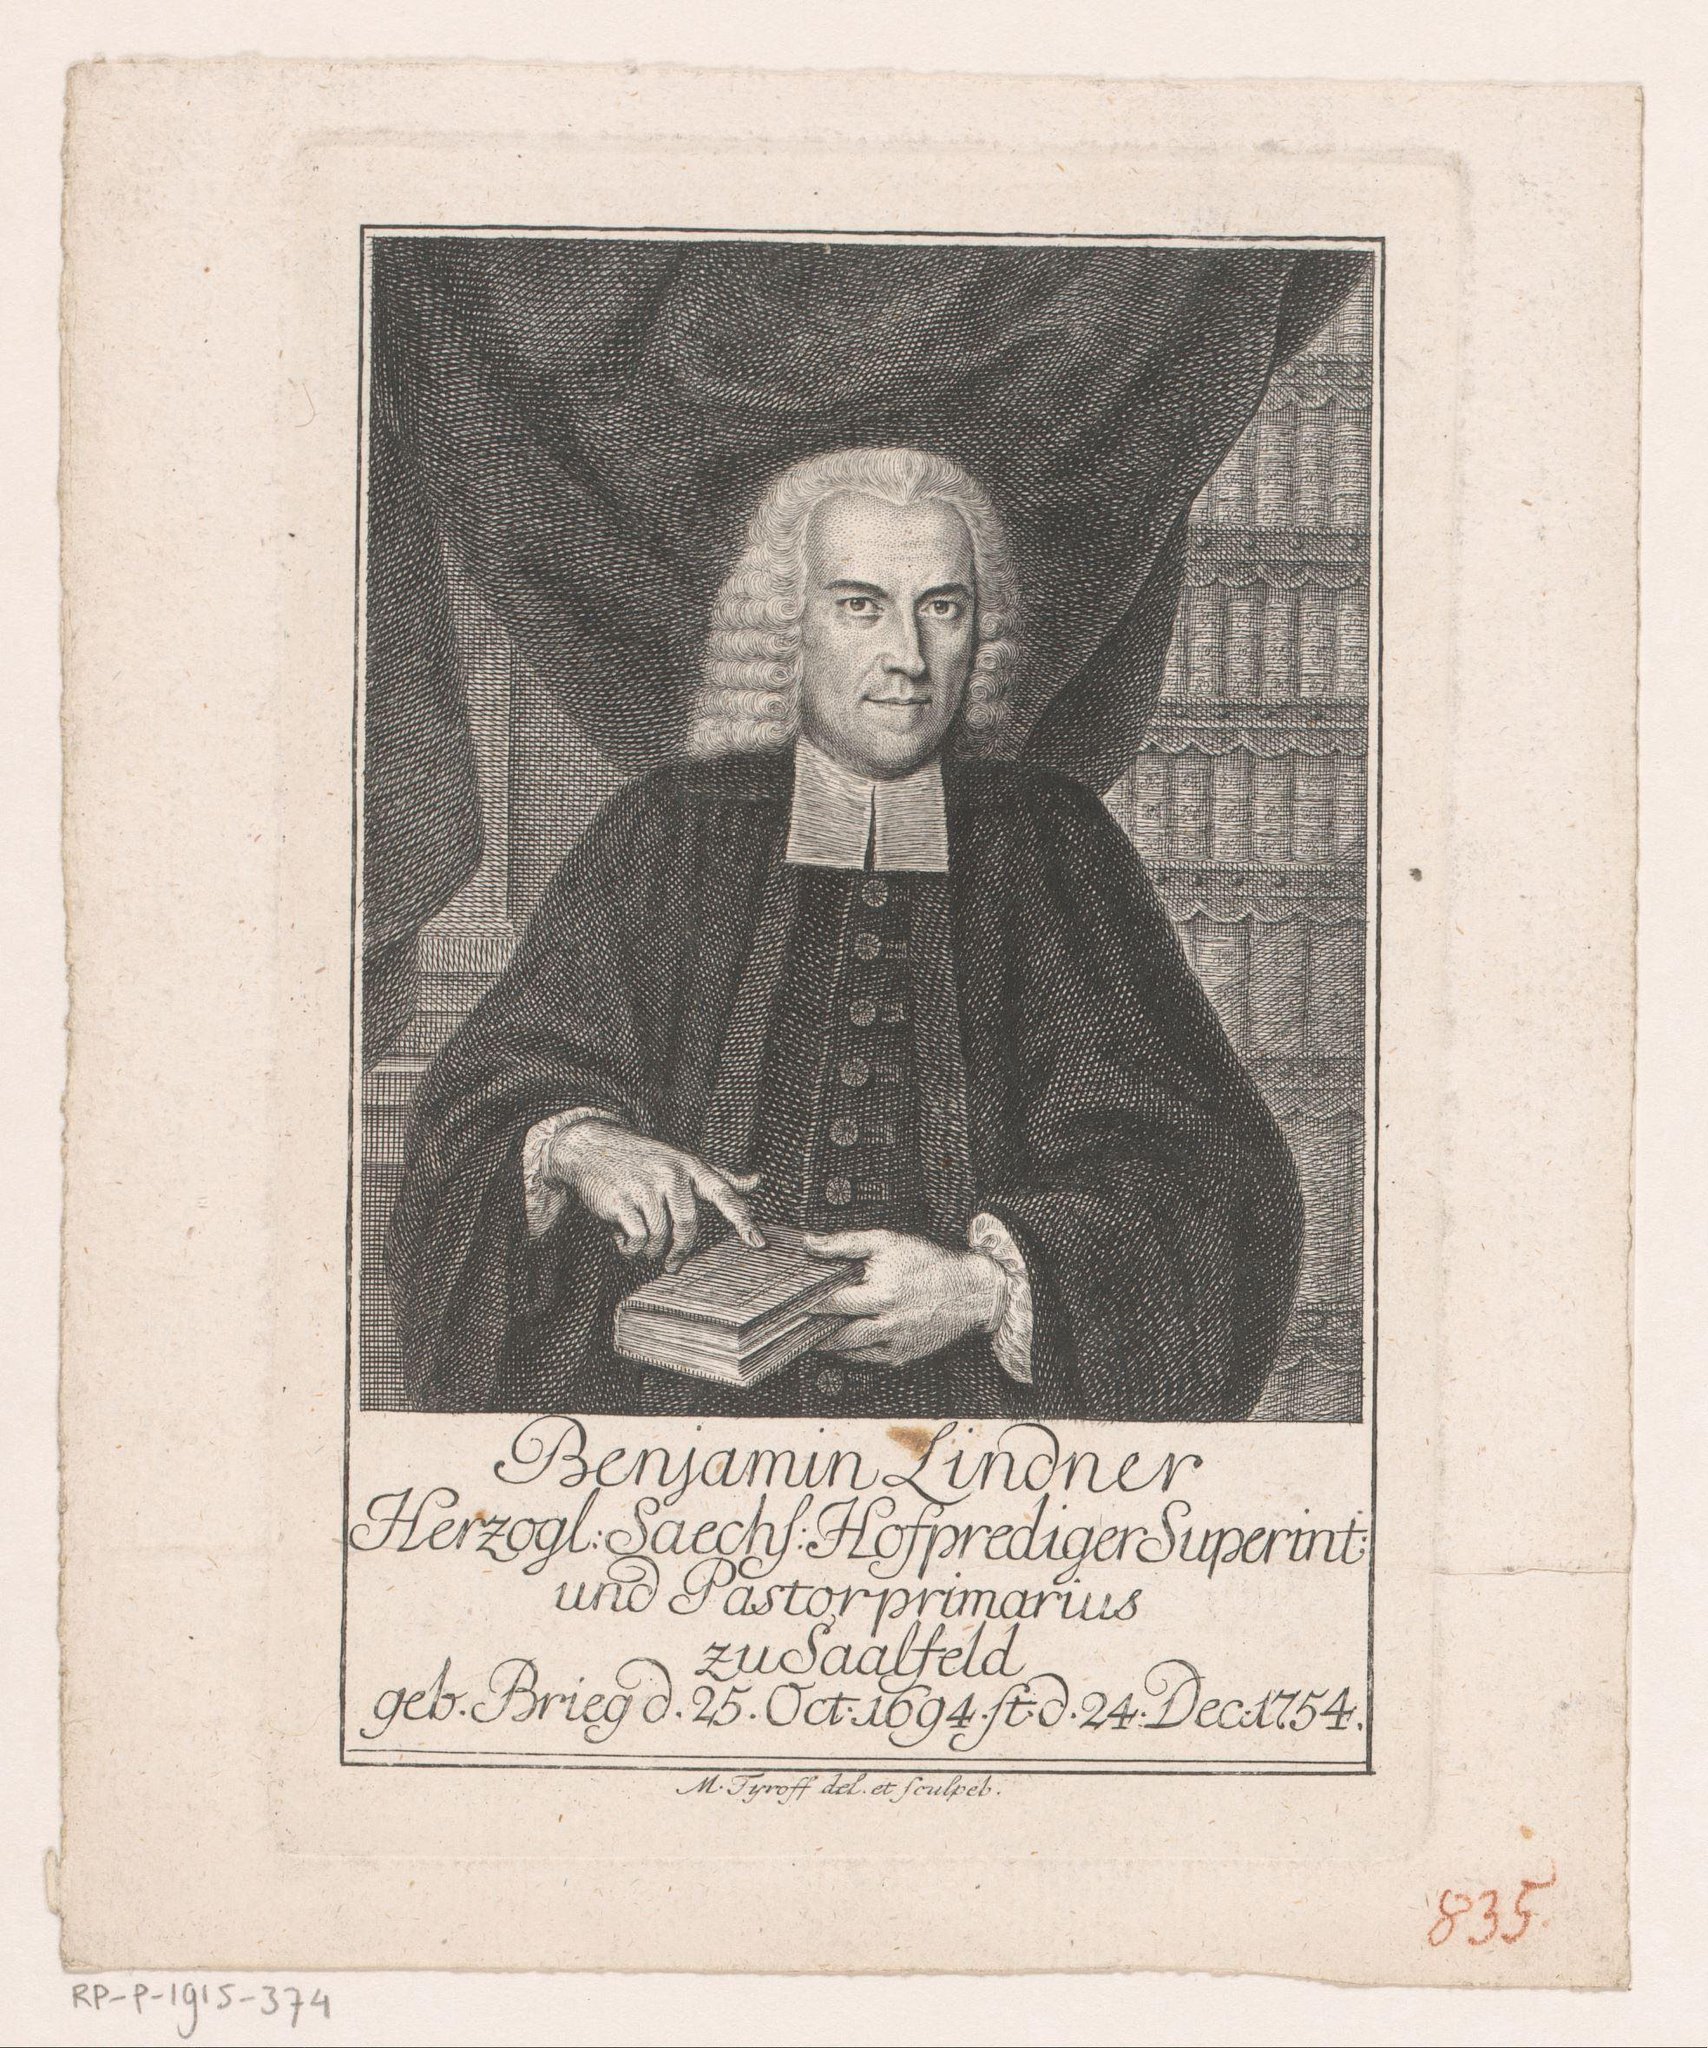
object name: print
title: Portret van Benjamin Lindner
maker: martin tyroff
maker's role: print maker, publisher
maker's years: 1704-1779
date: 1754-1779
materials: paper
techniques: engraving, etching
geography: germany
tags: bookshelves, historical persons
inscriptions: number: ‘835’, collector's mark: Lugt 2228